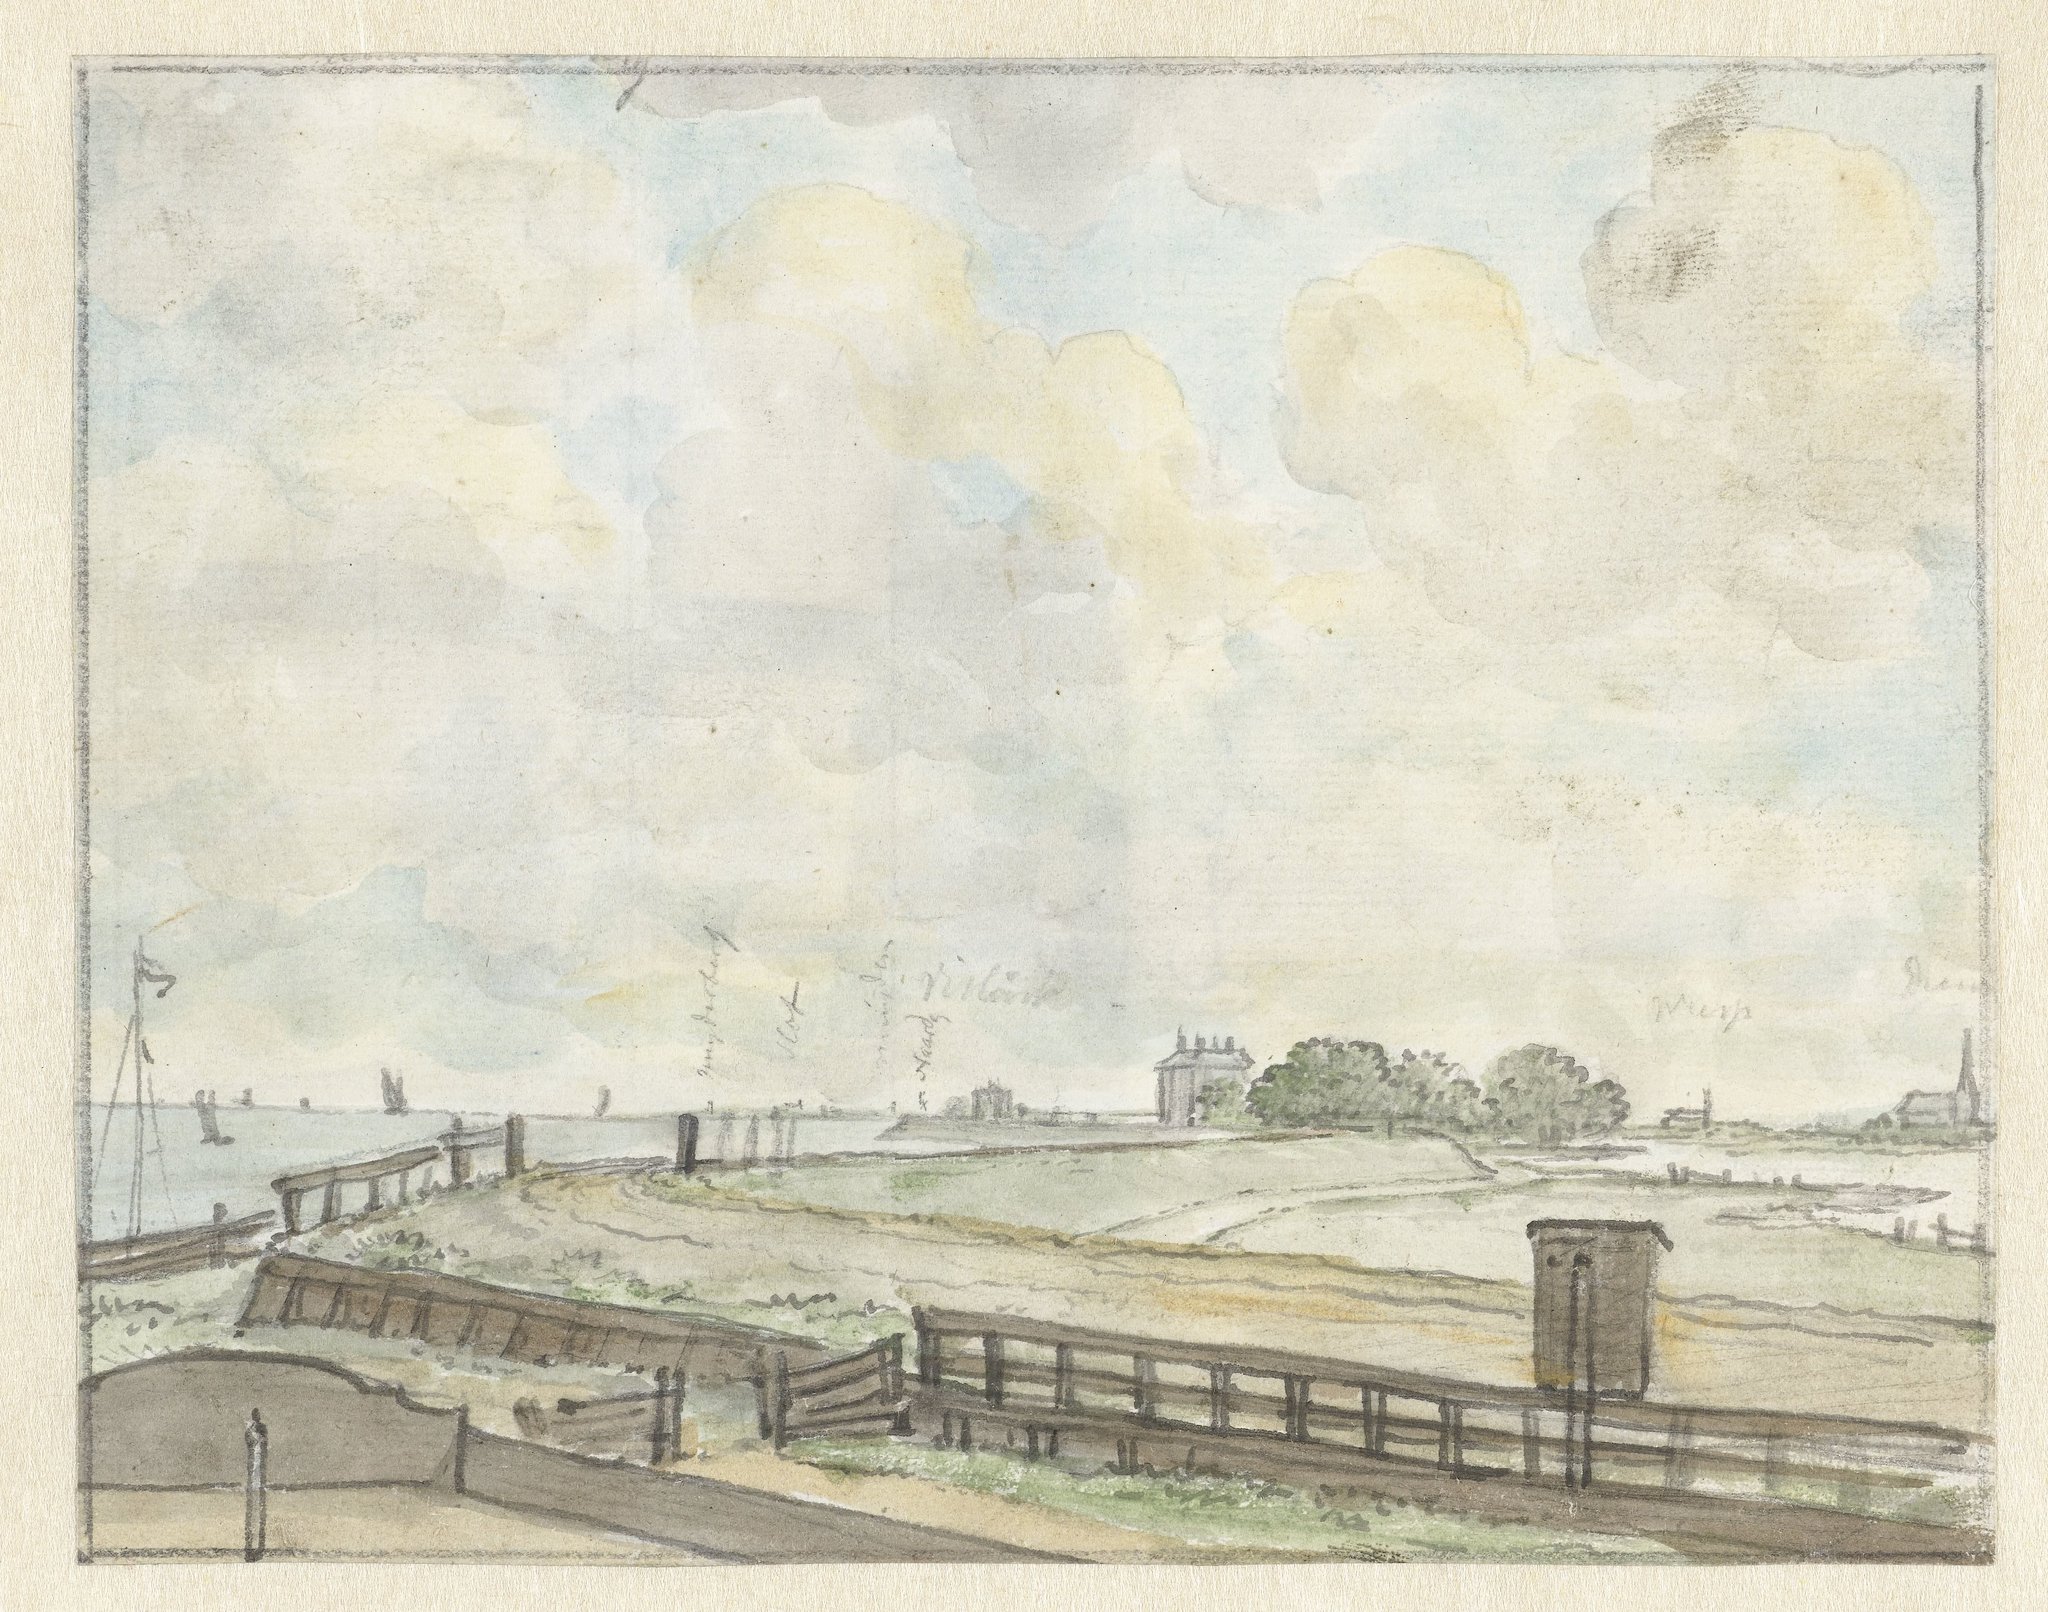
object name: drawing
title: Dijkgezicht buiten Amsterdam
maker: jurriaan andriessen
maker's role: draughtsman, painter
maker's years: 1742-1819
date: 1785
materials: ink, paper, pencil, watercolor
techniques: brush, pen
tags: prospect of city, town panorama, silhouette of city